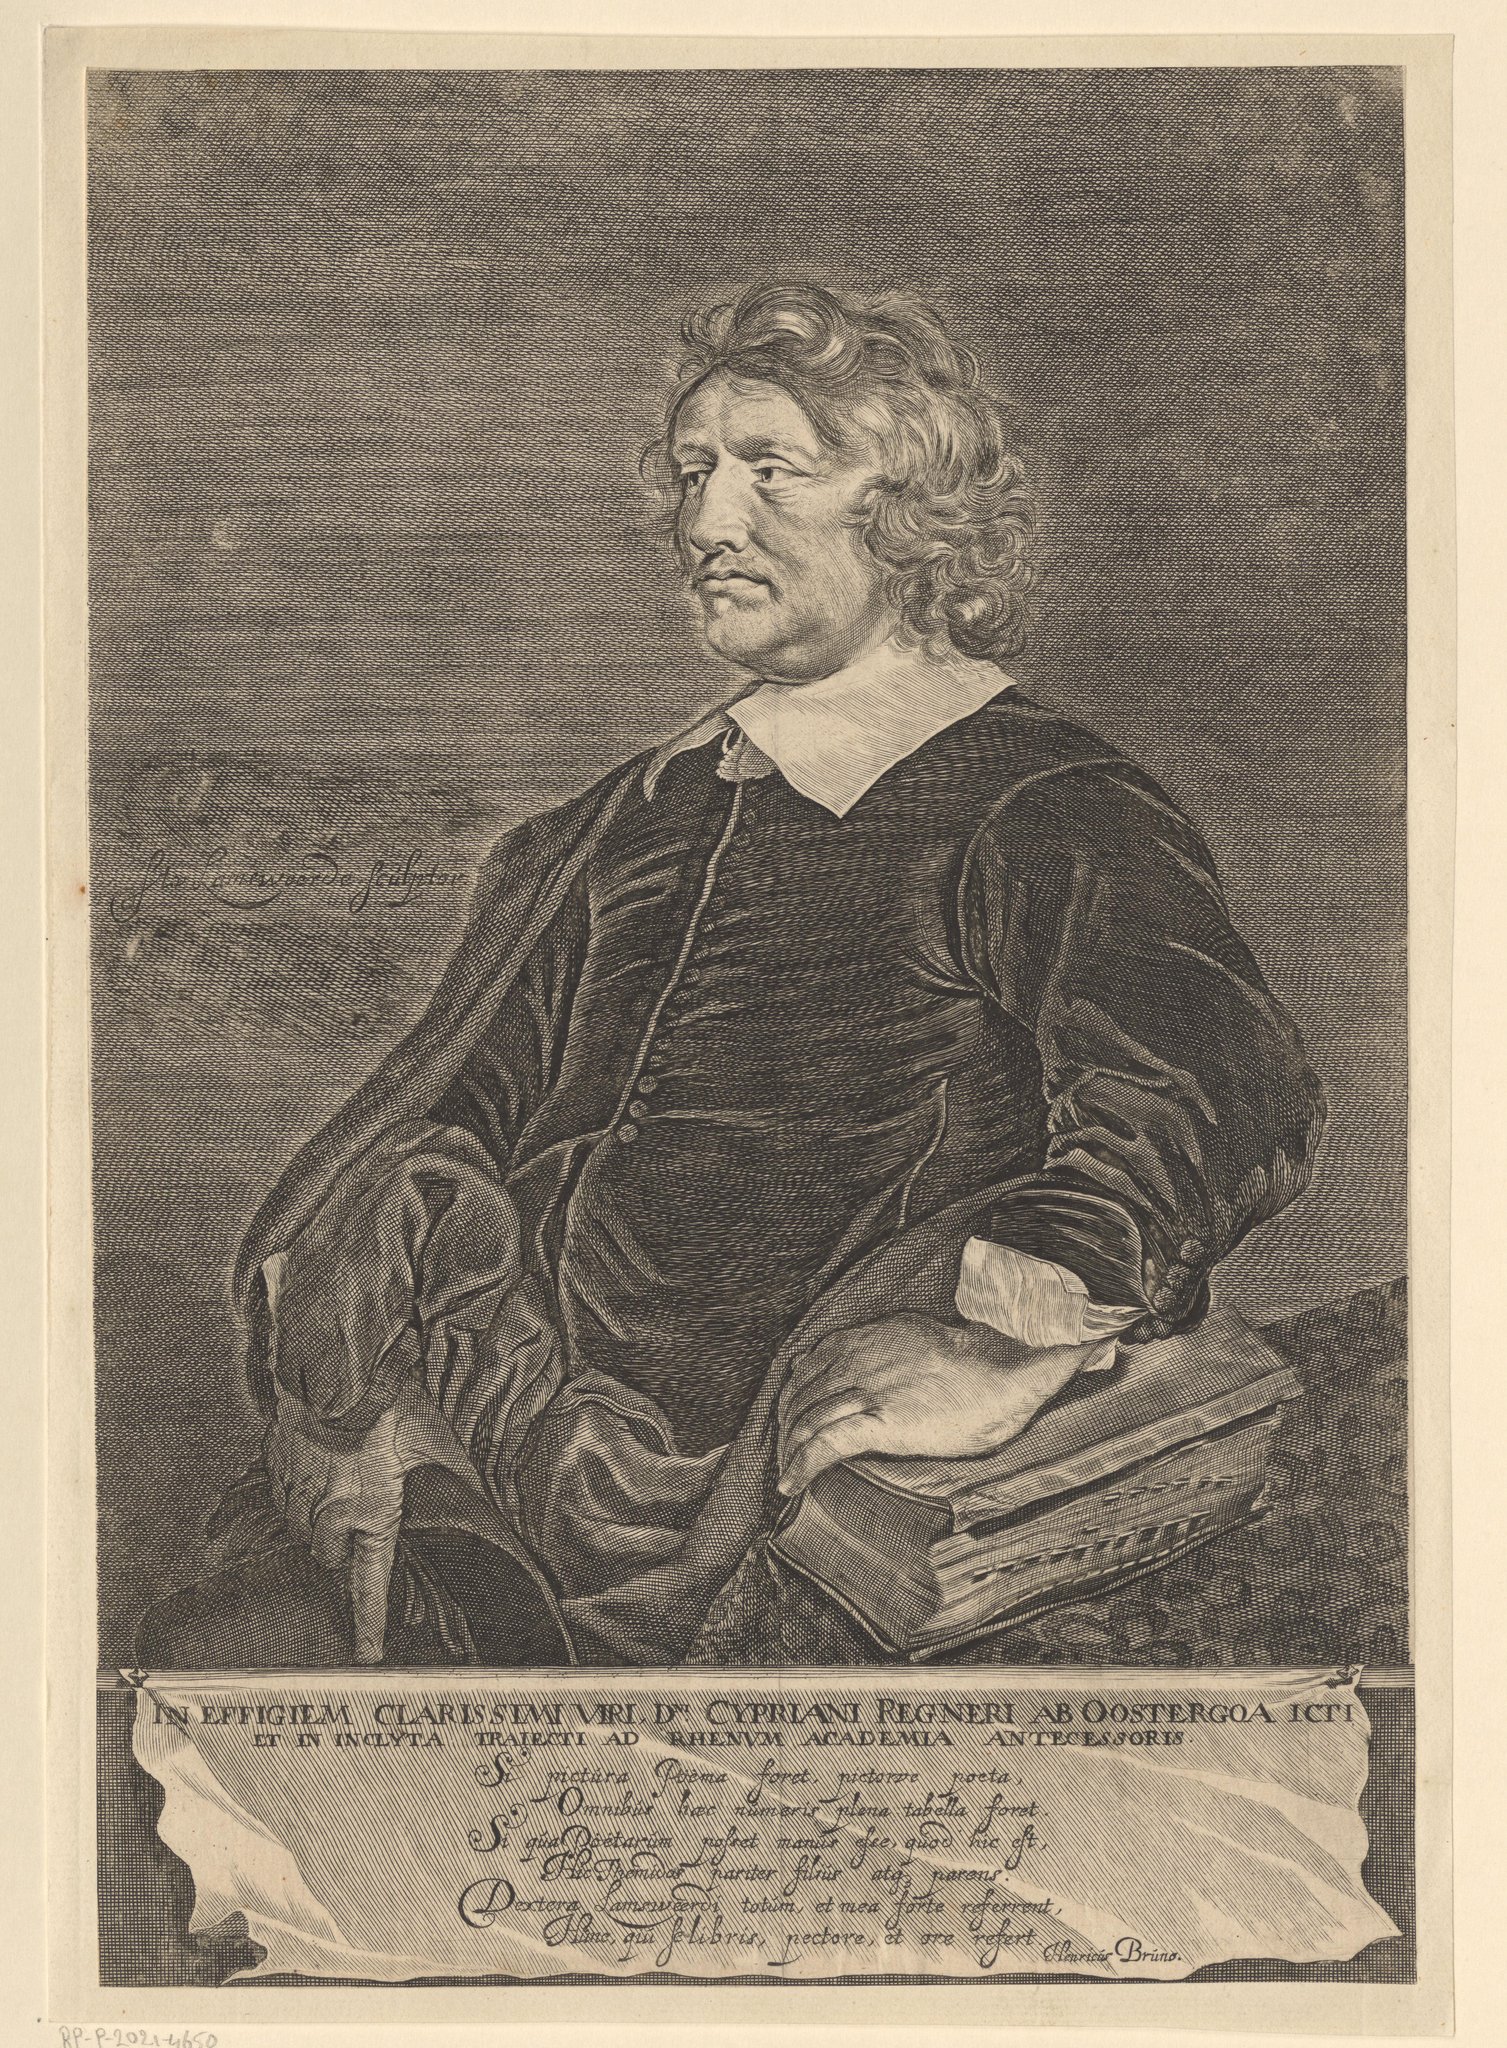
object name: print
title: Portret van Cyprian Regnier van Oostergoa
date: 1620-1686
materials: paper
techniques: engraving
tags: gloves, mittens, etc., historical persons, book